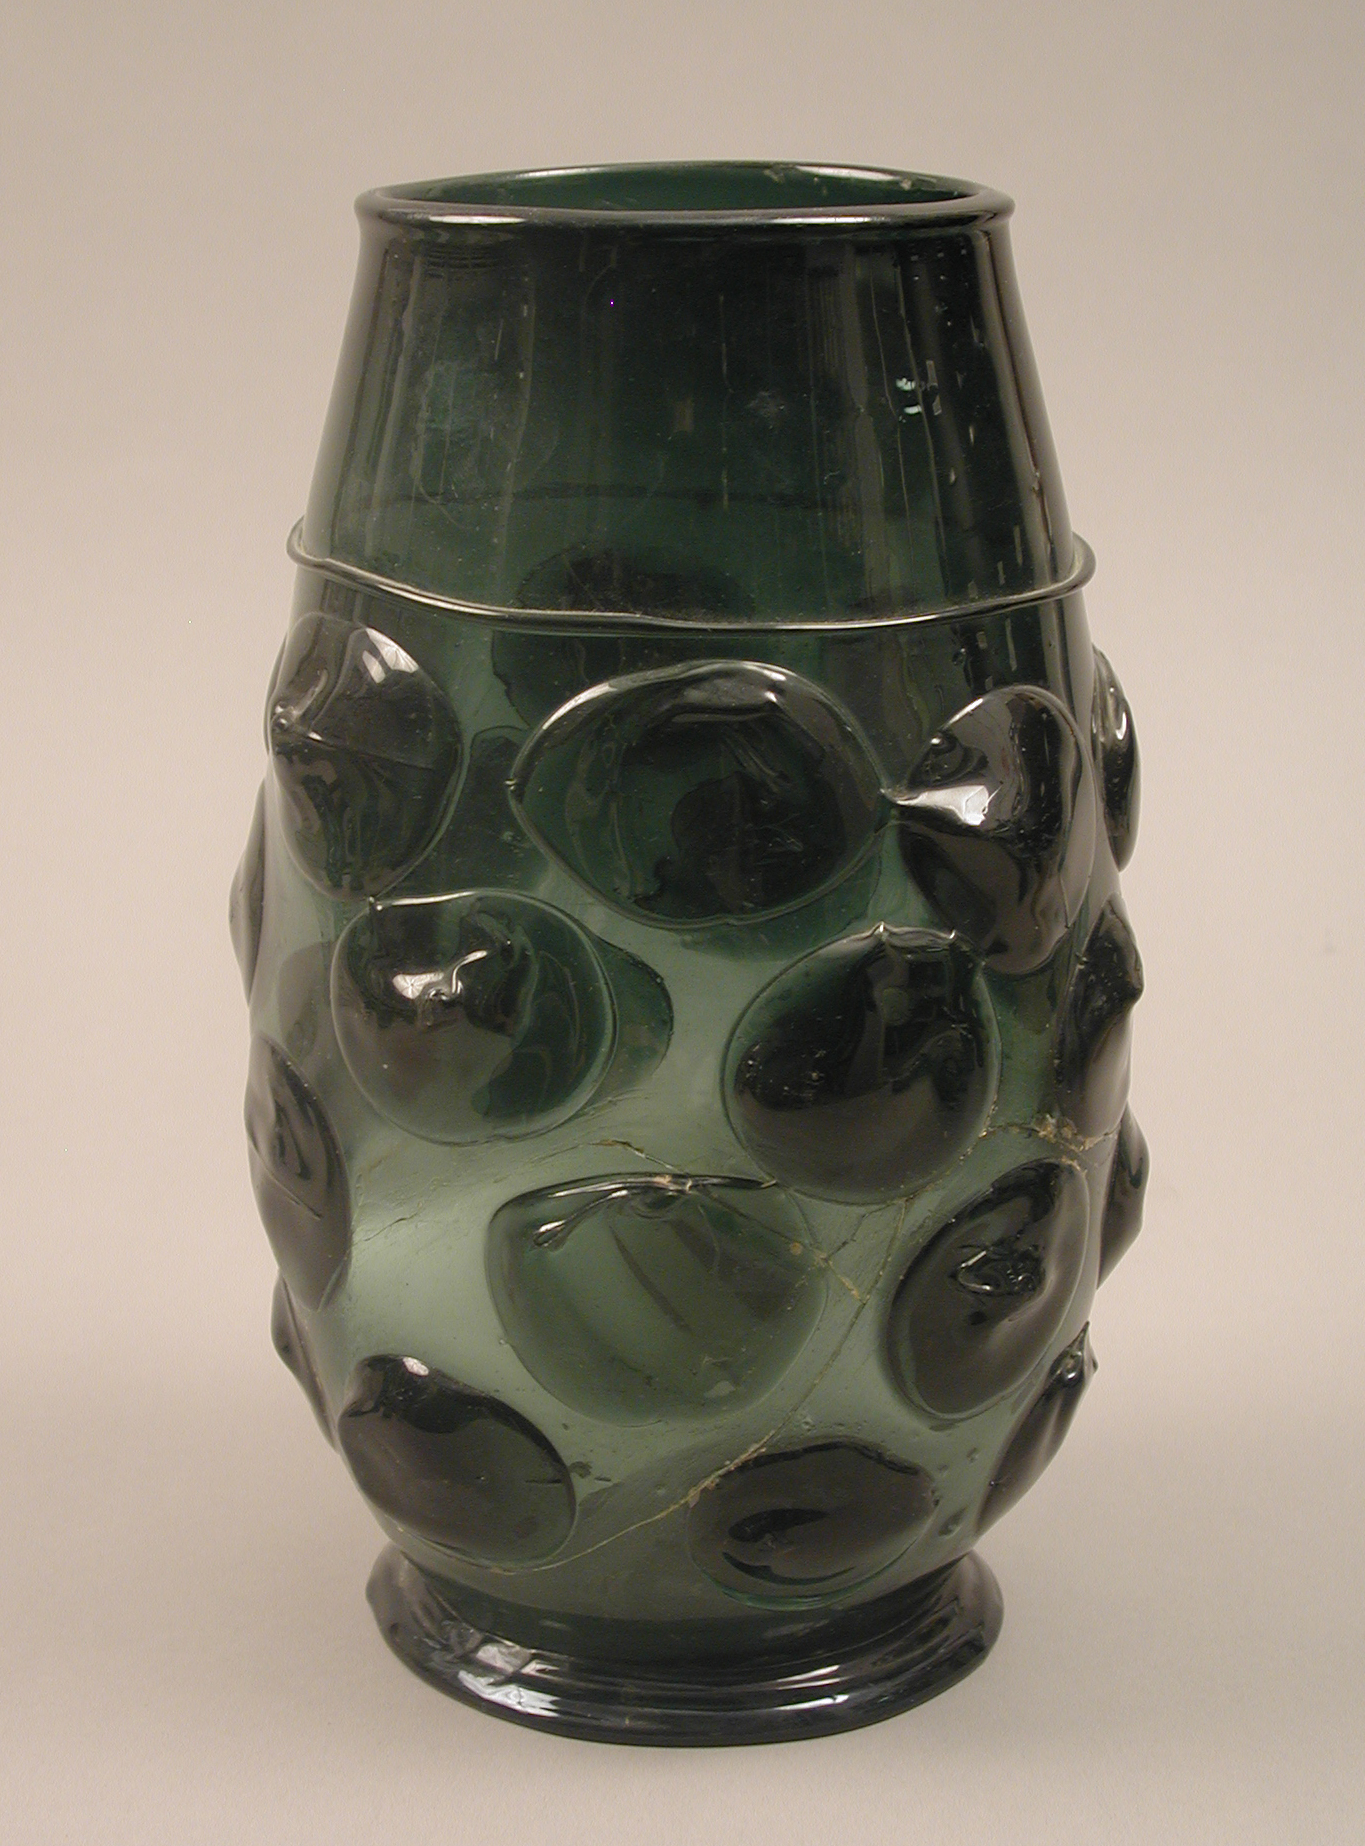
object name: beaker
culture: german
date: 1534-1566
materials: glass